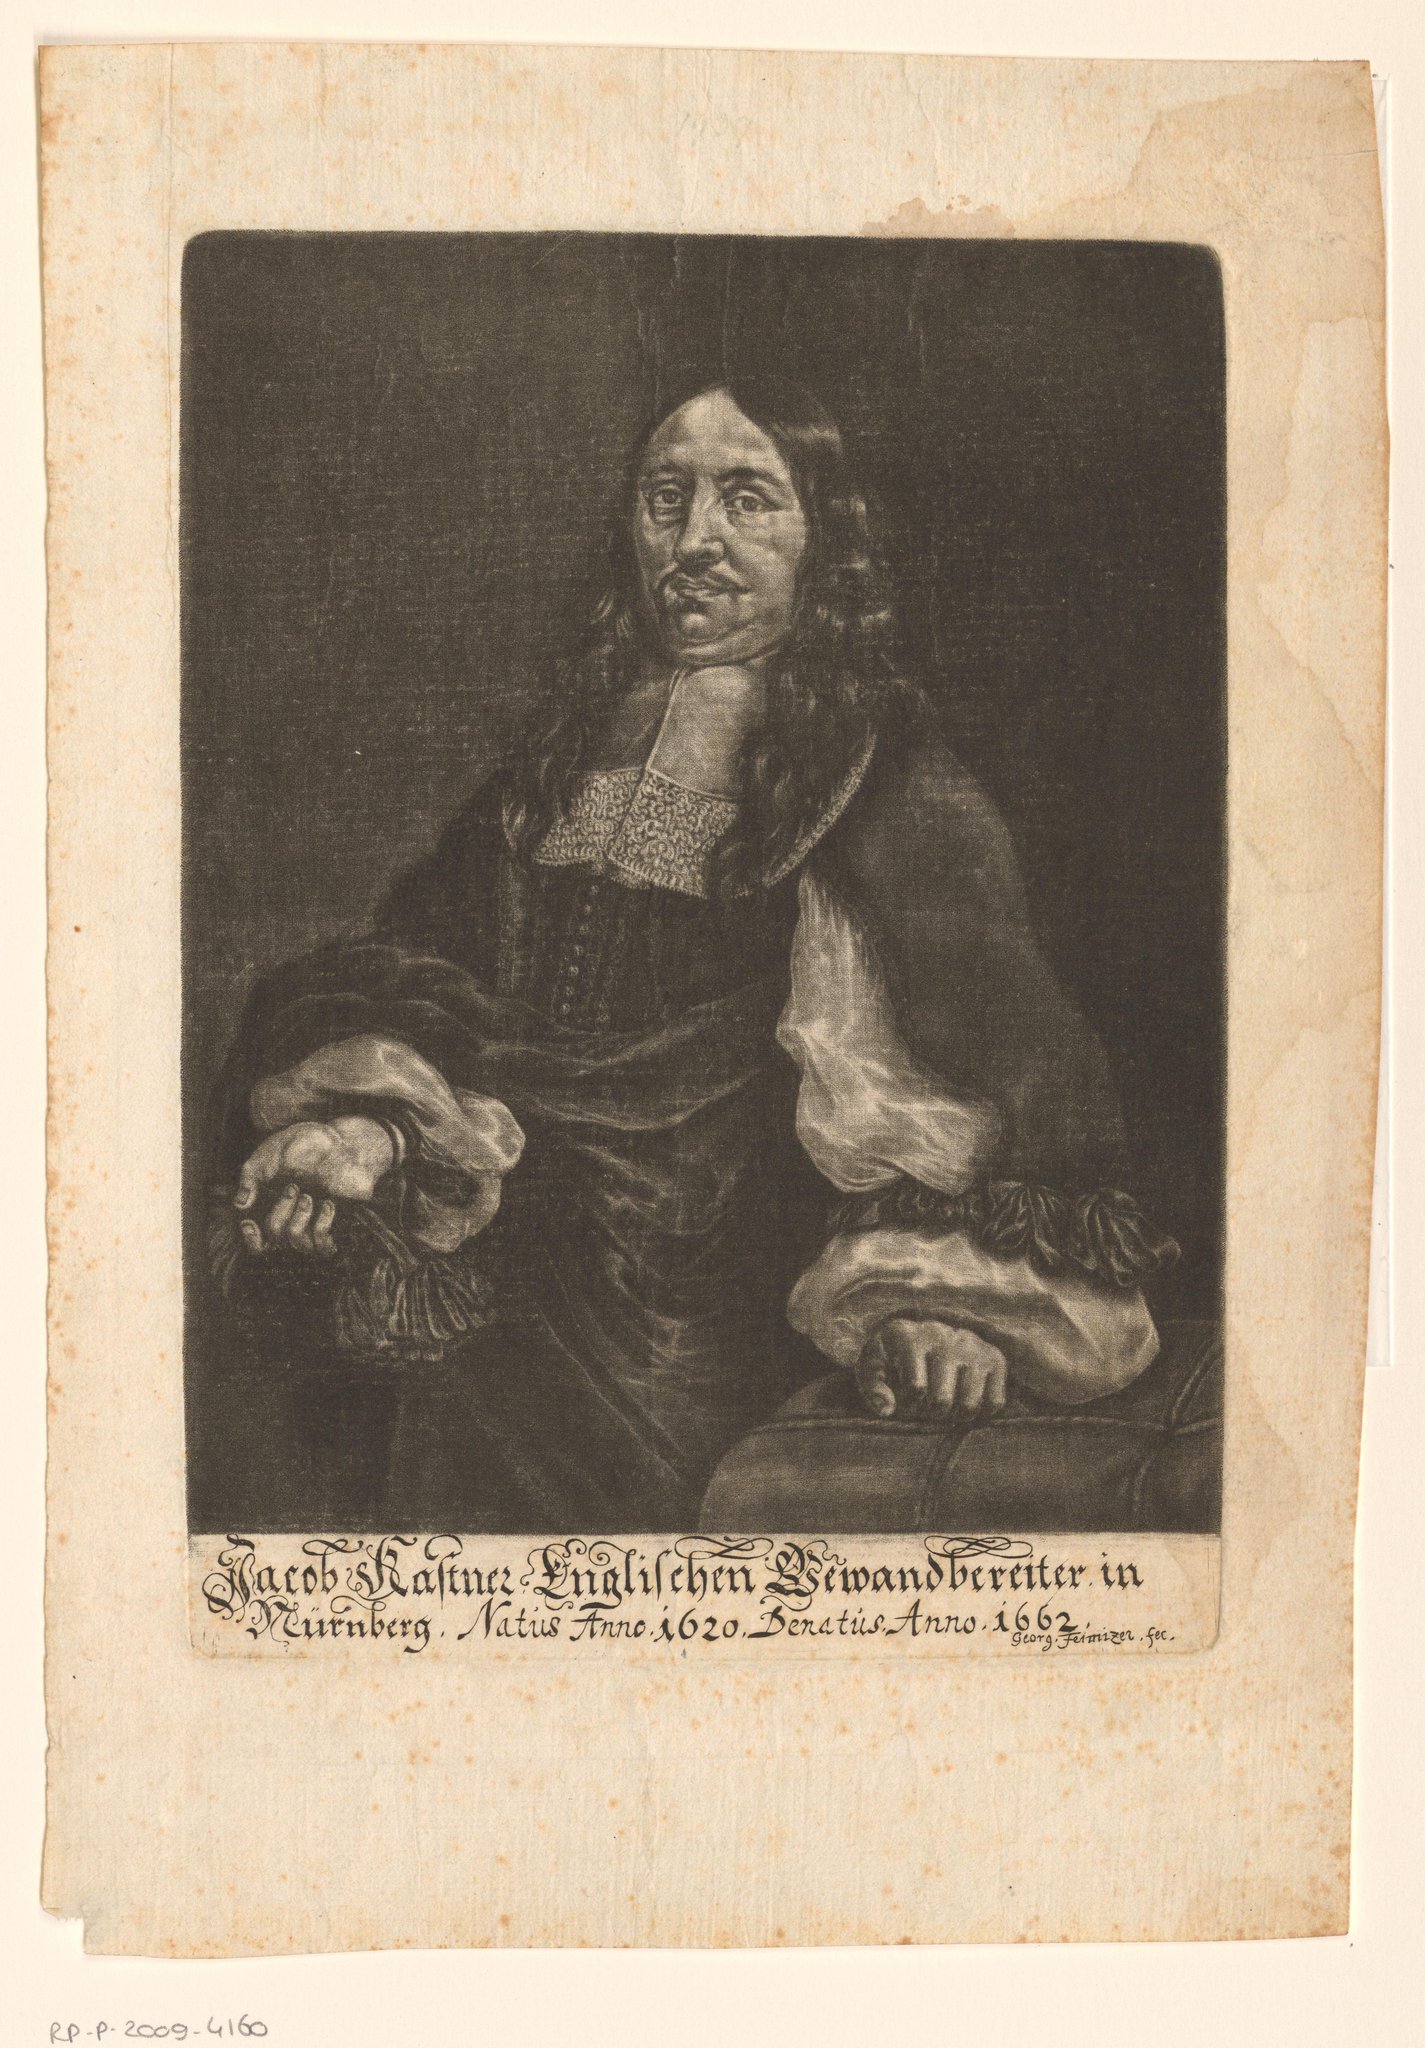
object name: print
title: Portret van Jacob Kastner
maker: georg feimizer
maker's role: print maker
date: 1642-1662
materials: paper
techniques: mezzotint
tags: tailor, dressmaker, ornamental parts of clothing, neck-gear ~ clothing (bands) (+ men's clothes)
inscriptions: caption: ‘Jacob Kastner. Englischen gewandbereiter in Nürnberg. Natus Anno 1620. Denatus Anno 1662.’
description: Portret van Jacob Kastner (1620-1662), Engelse kleermaker te Nurnberg. Bef. Wijde mouw met split, poffende ondermouwen. Passementen(?) in de hand.